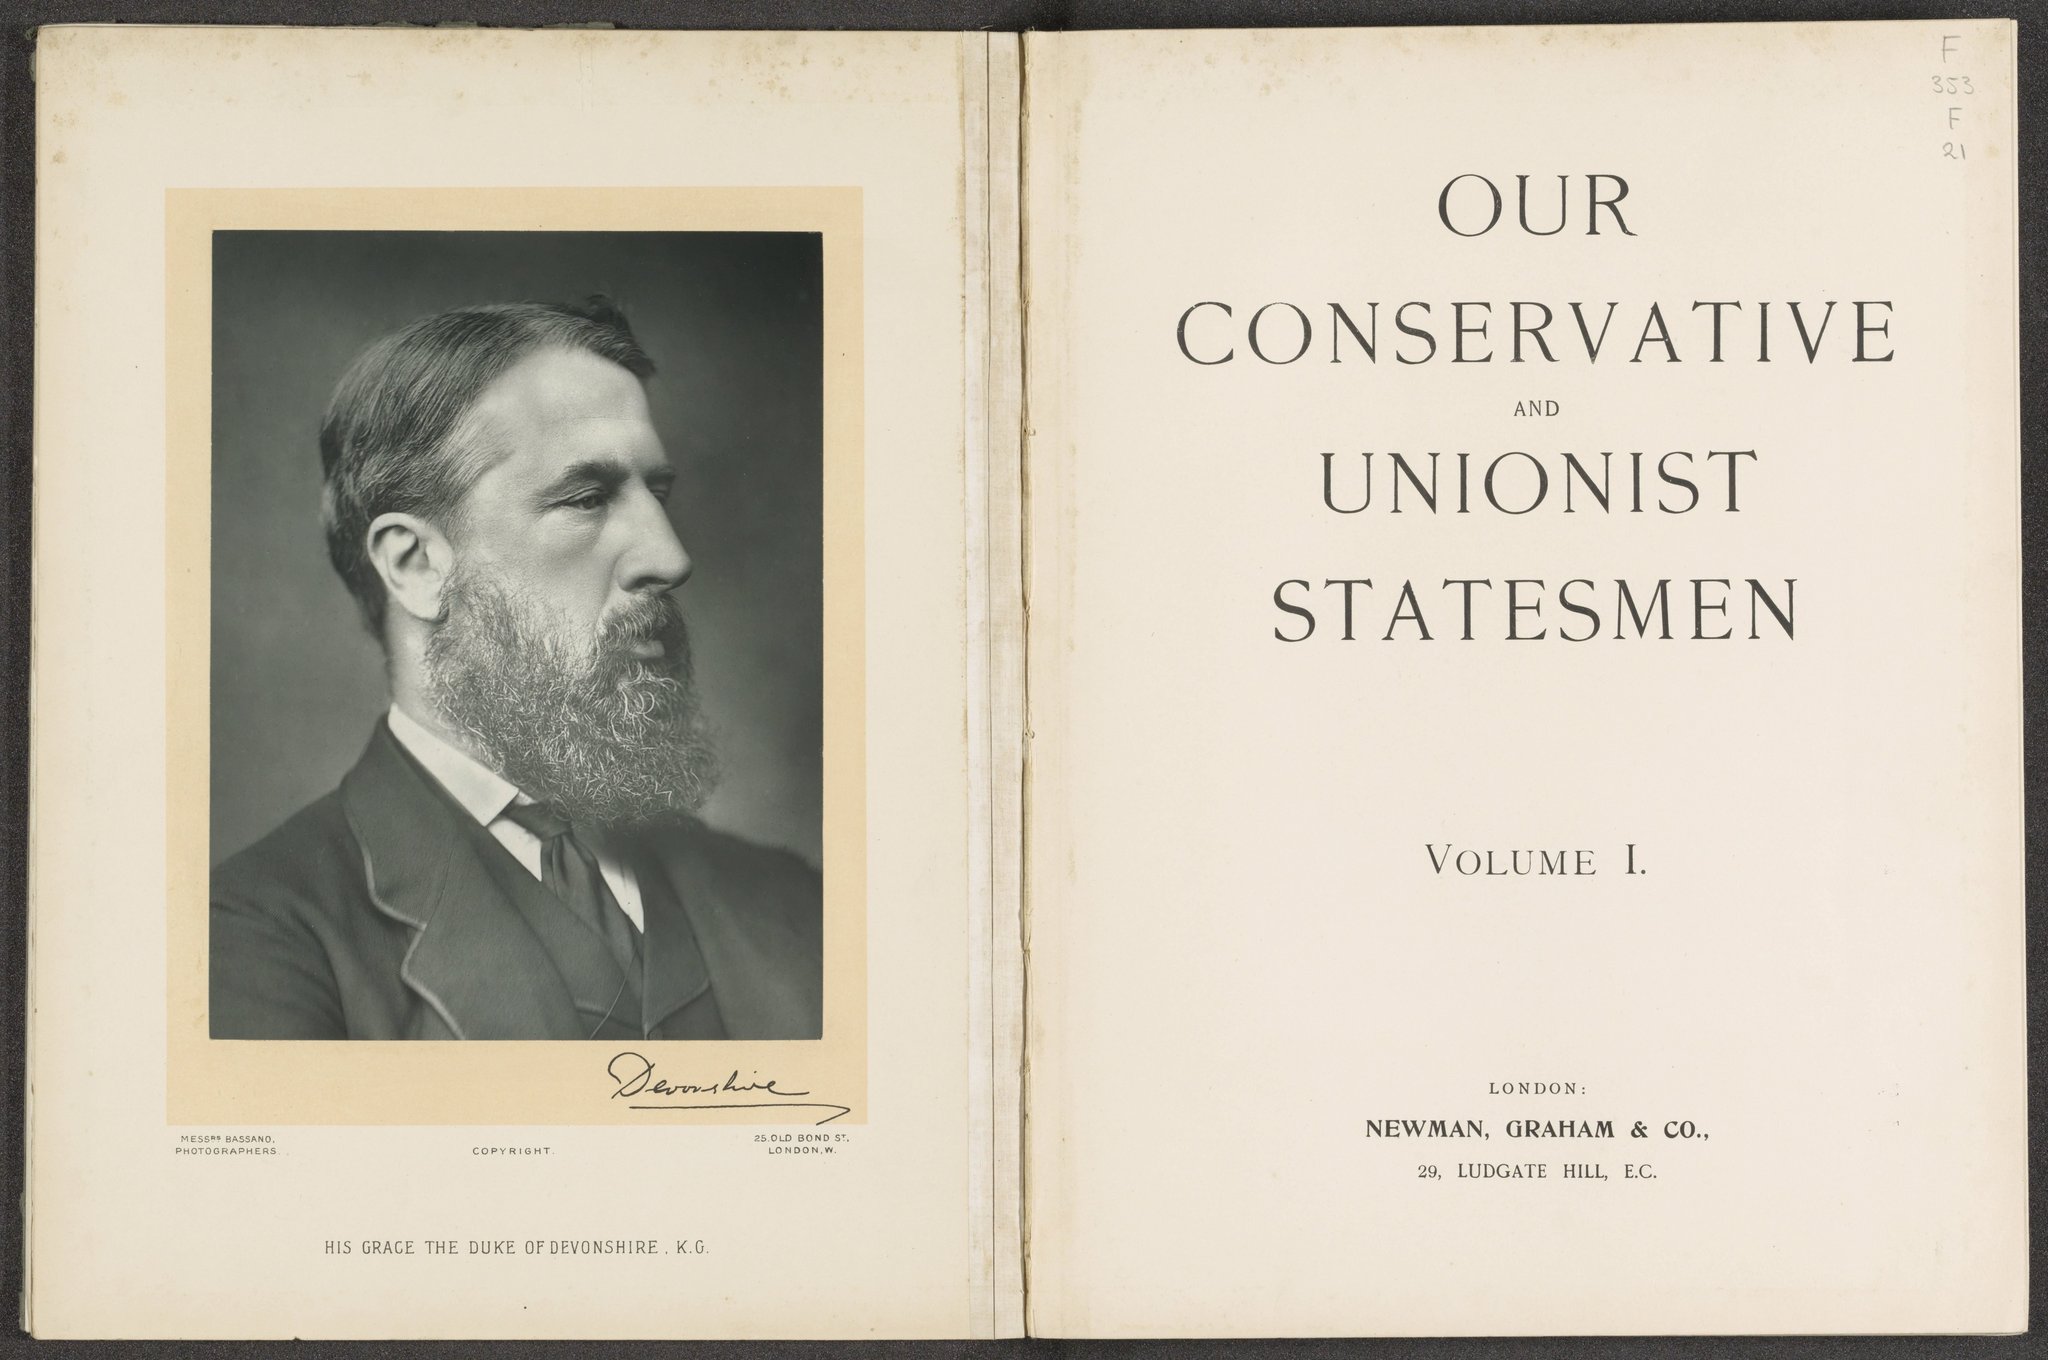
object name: page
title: His grace the duke of Devonshire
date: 1893-1903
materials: paper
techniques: carbon print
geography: london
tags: historical persons (portraits and scenes from the life) (+ (full) bust portrait)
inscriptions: inscription: ‘25 Old Bond St. London, W.’, annotation